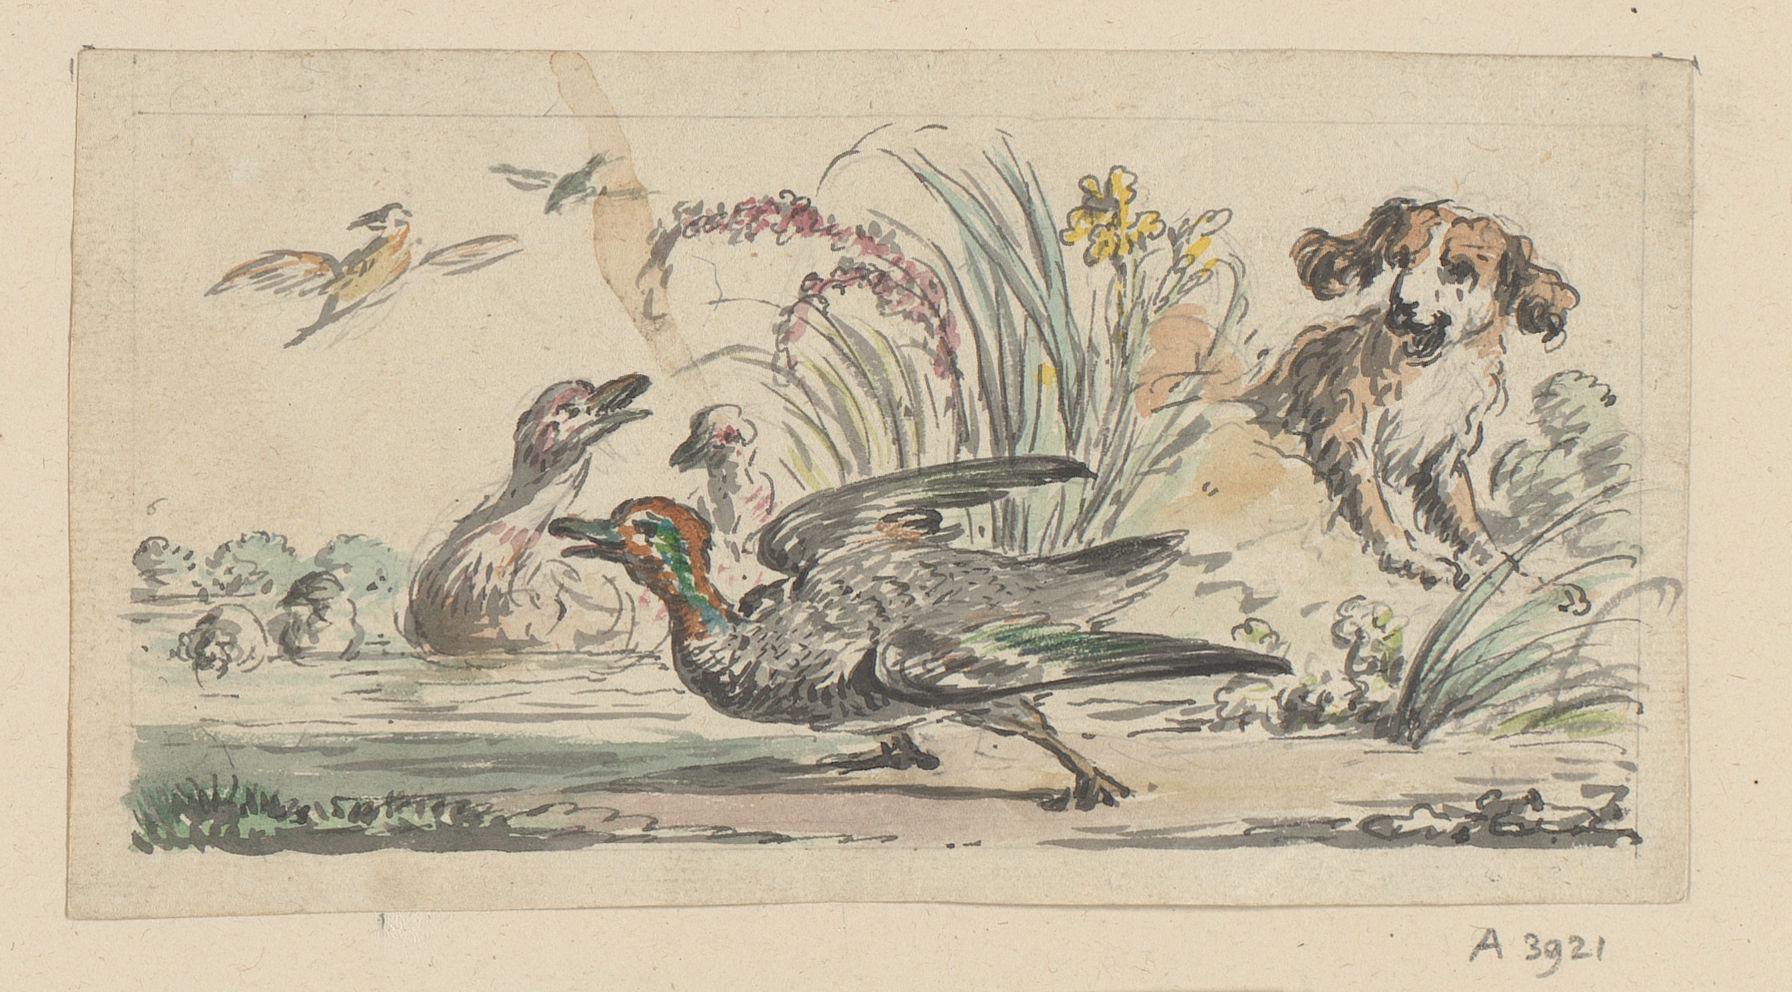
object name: drawing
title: Waterkant met eenden die schrikken van een hond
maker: abraham van strij (i)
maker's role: draughtsman, painter, print maker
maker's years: 1753-1826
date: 1763-1826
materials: paint, paper, pencil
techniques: brush, pen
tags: water-birds: duck, dog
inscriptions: collector's mark: Lugt 2228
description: De tekeningen van Abraham van Strij zijn op een later moment ingevoegd in het album met tekeningen van Jurriaan Andriessen.